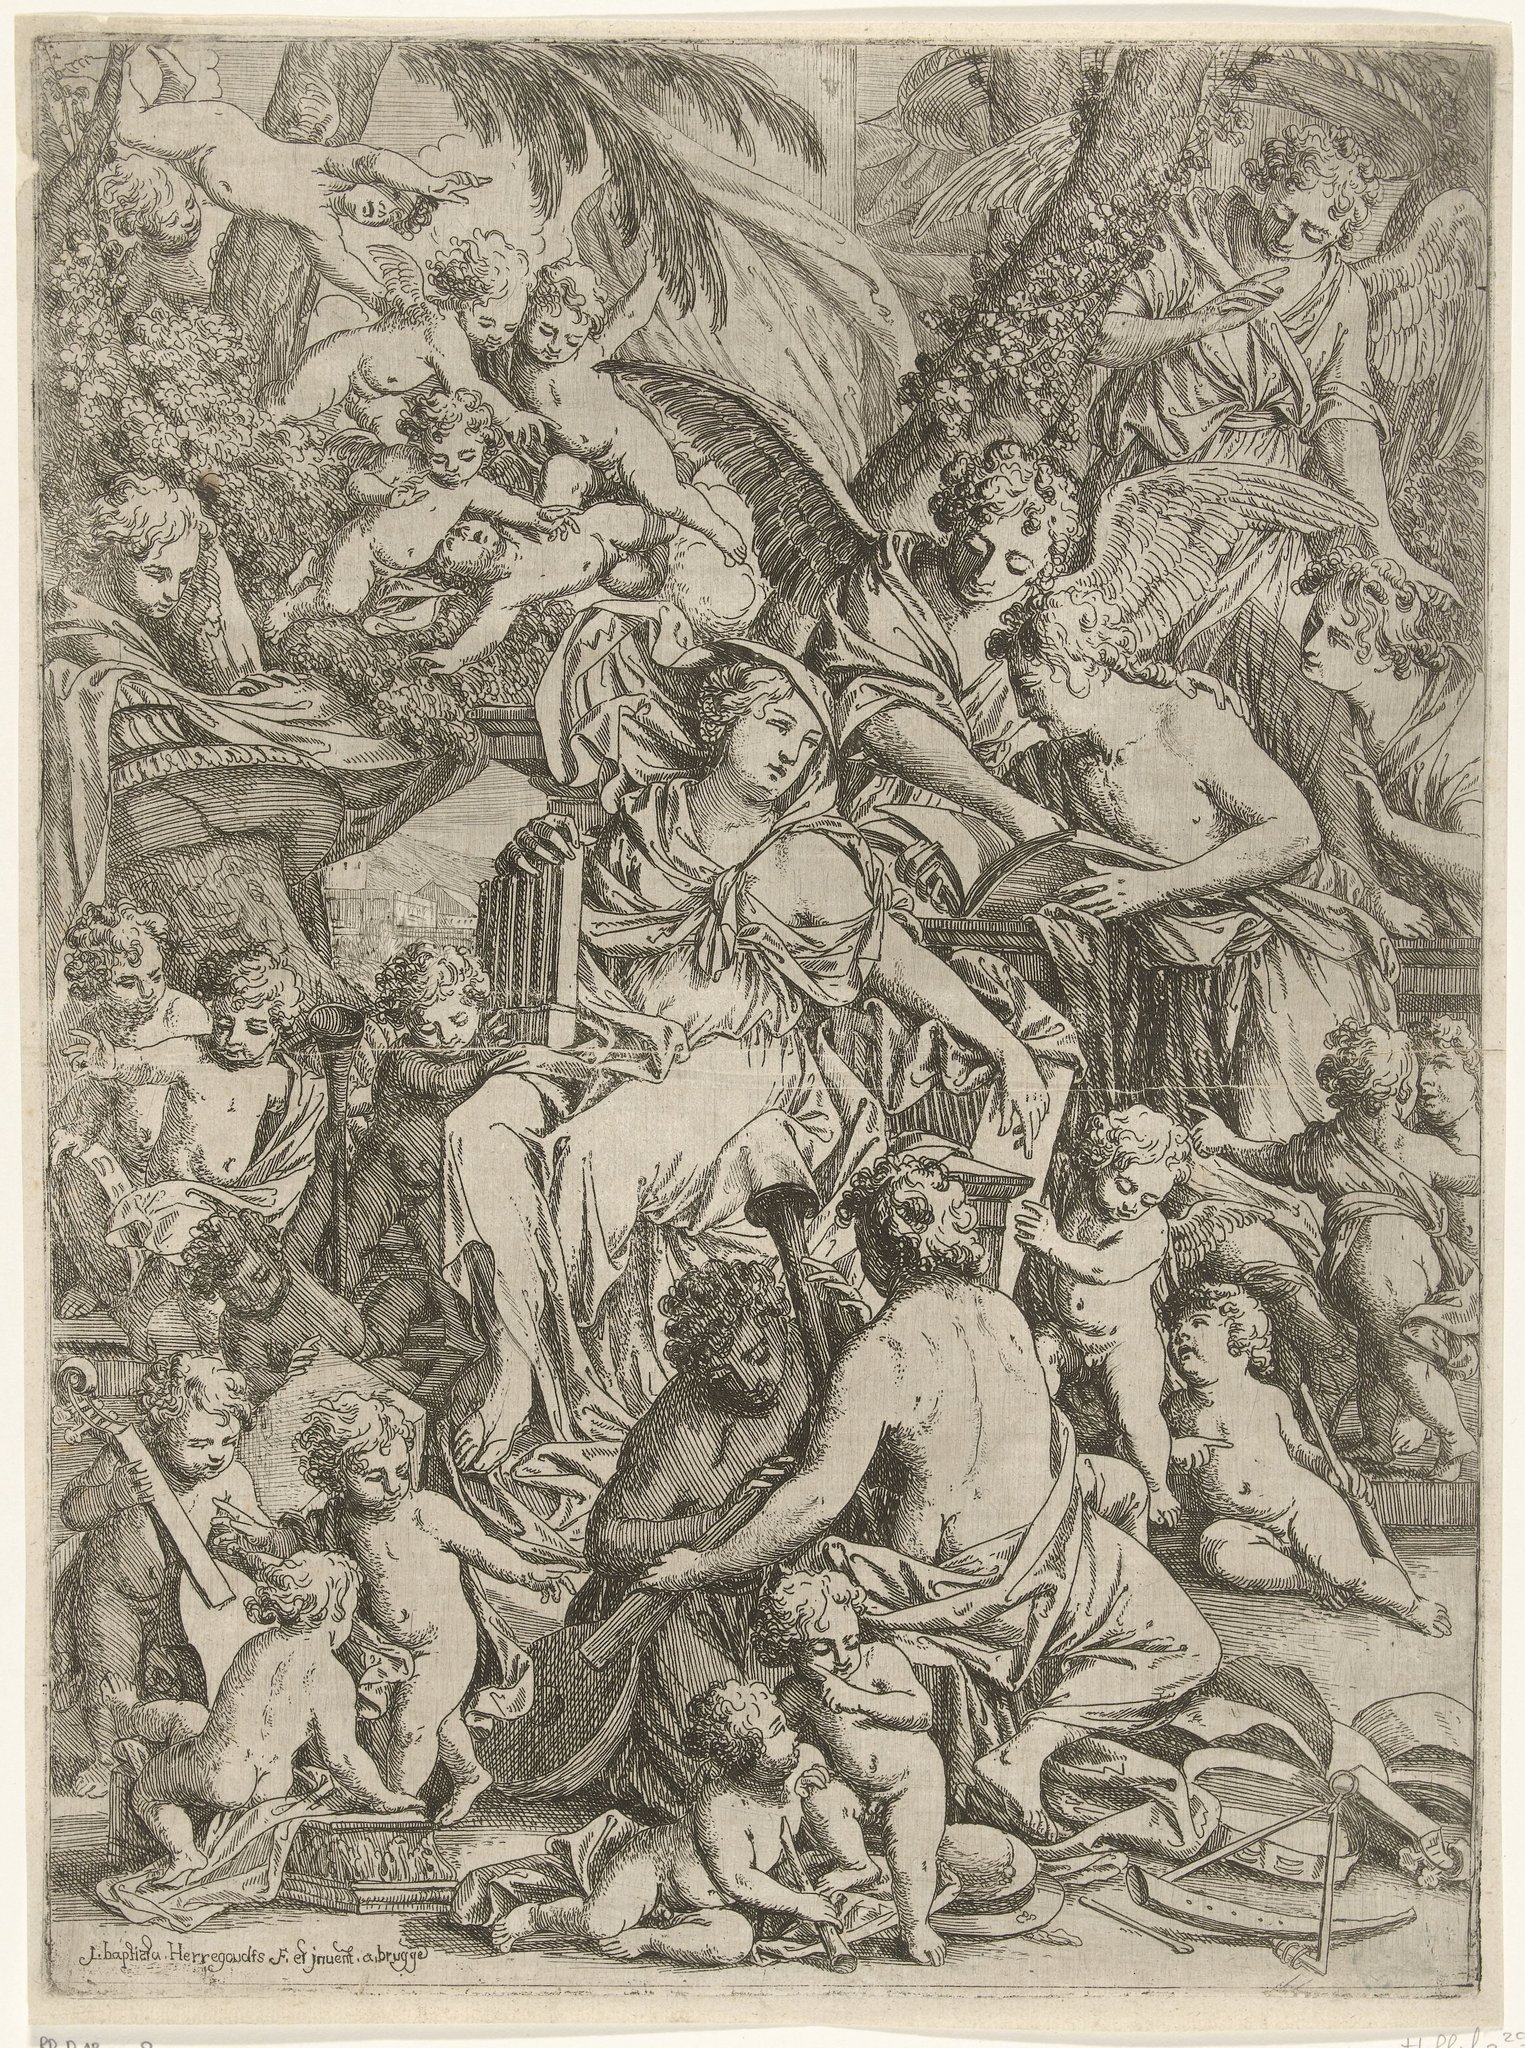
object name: print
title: H. Cecilia met orgel in de hand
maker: jan baptist herregouts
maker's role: print maker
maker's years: 1640-1721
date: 1682-1721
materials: paper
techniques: etching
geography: bruges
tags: angels, st. cecilia as patroness of music, angel(s) represented as child(ren) - gg - lower angel(s) without wings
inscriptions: collector's mark: Lugt 2228, collector's mark: Lugt 2165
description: De heilige Cecilia zittend onder een boom met een orgel in de hand, omringd door engelen met verschillende muziekinstrumenten.